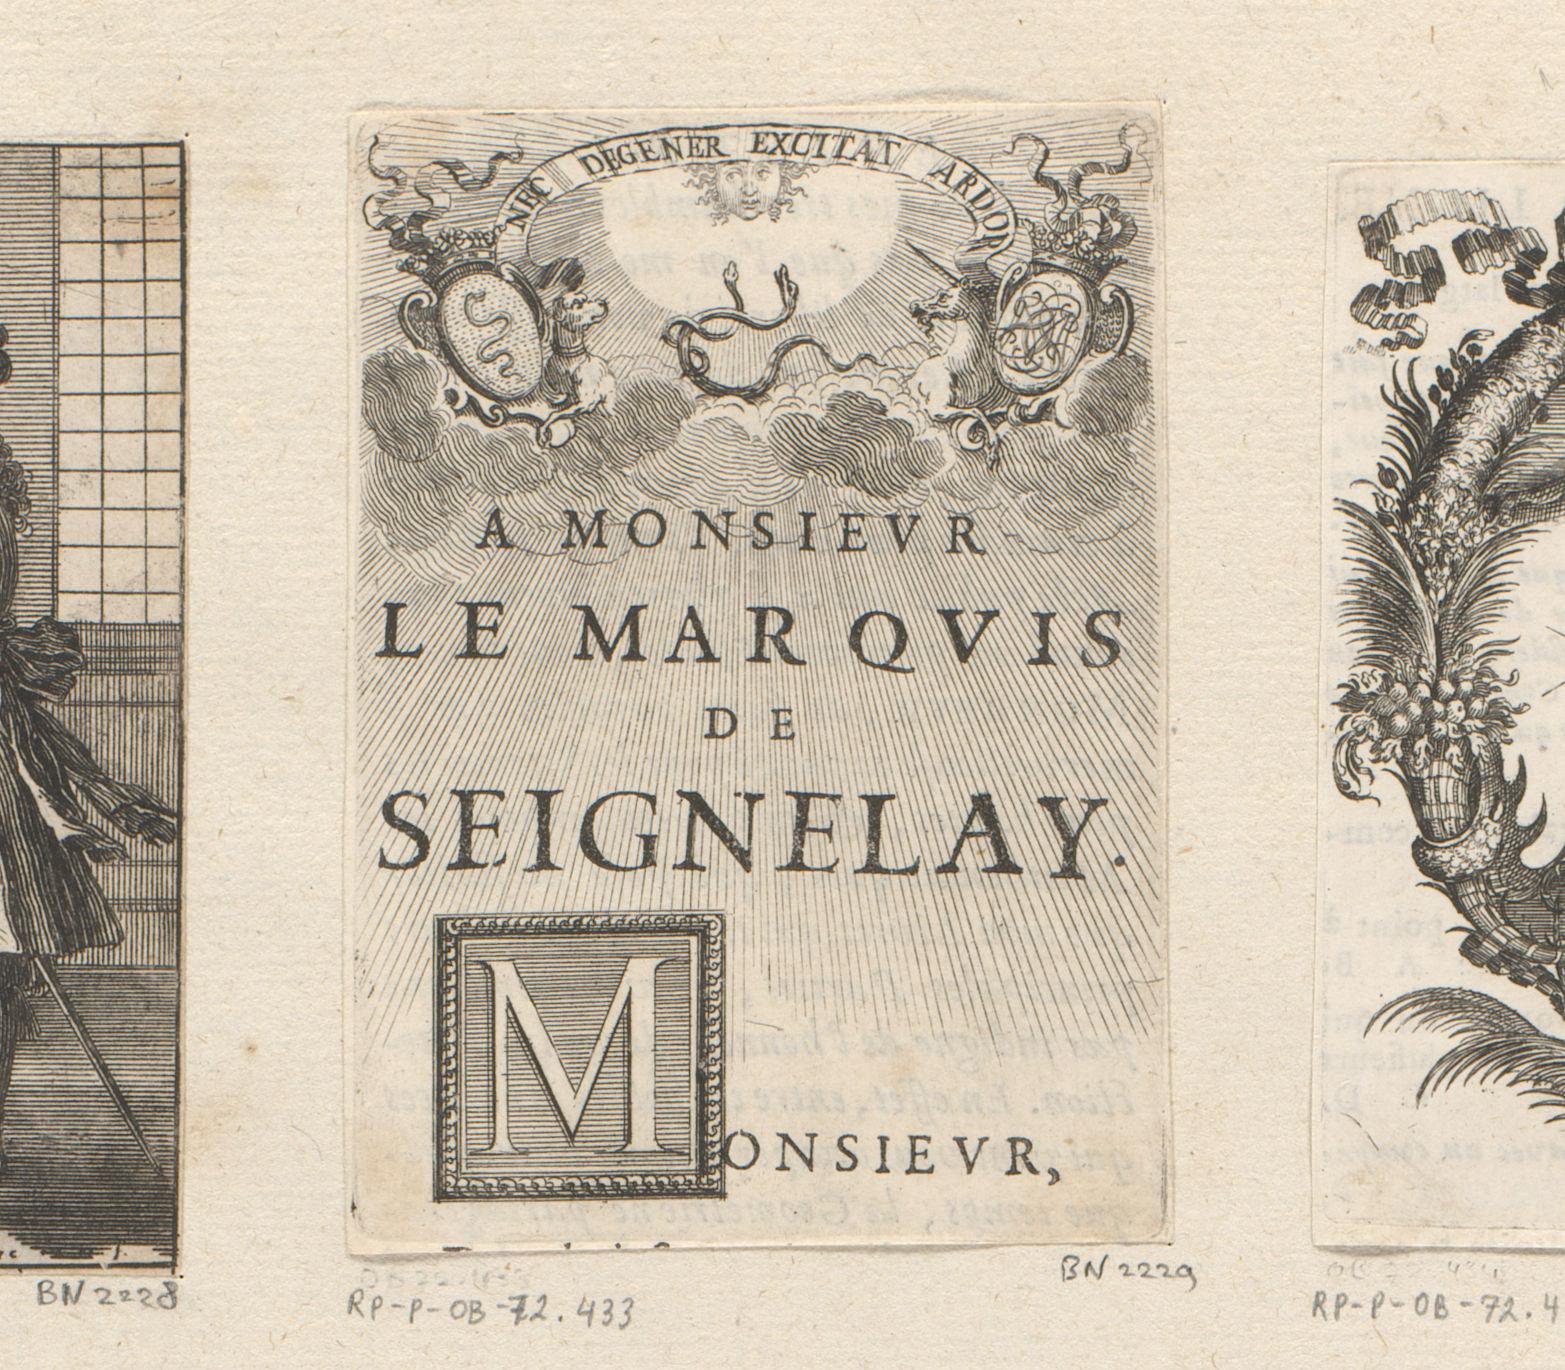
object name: book illustration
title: Opdracht met wapenschilden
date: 1669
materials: paper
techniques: etching, letterpress printing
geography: france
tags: armorial bearing, heraldry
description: Prent uit: Pratique de la géometrie, sur le papier et sur le terrain. Avec un nouvel ordre et une méthode particulière. Parijs: Thomas Jolly, 1669.